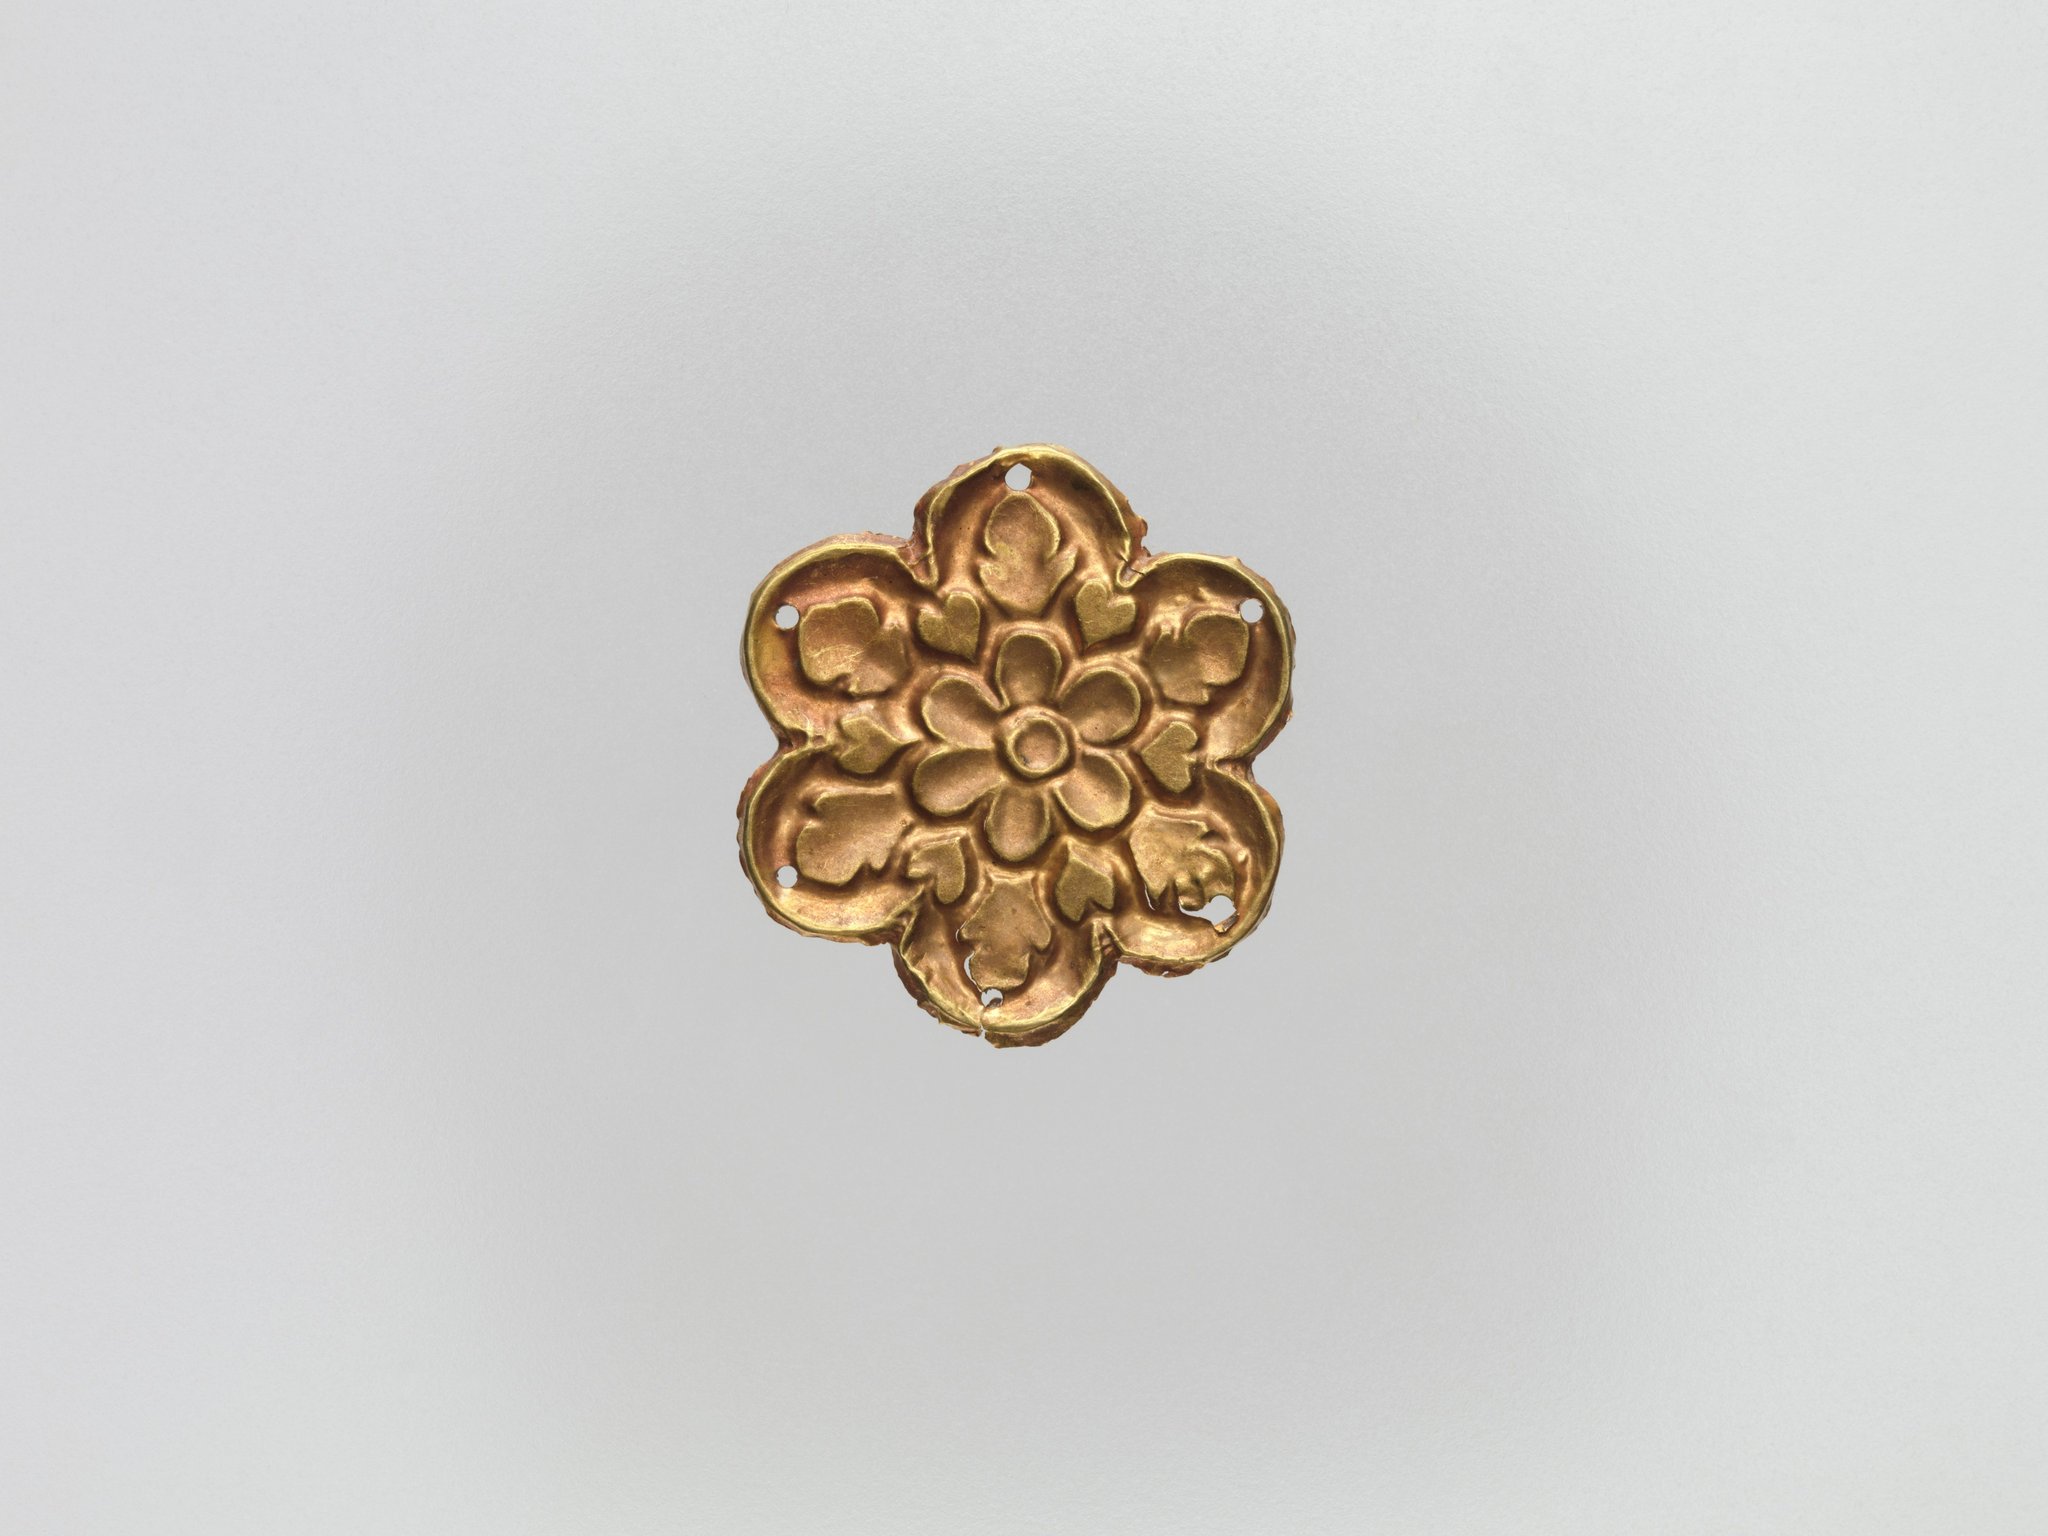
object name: garment plaque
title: Flower-Shaped Clothing Plaque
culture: chinese or central asian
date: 601-900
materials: gold